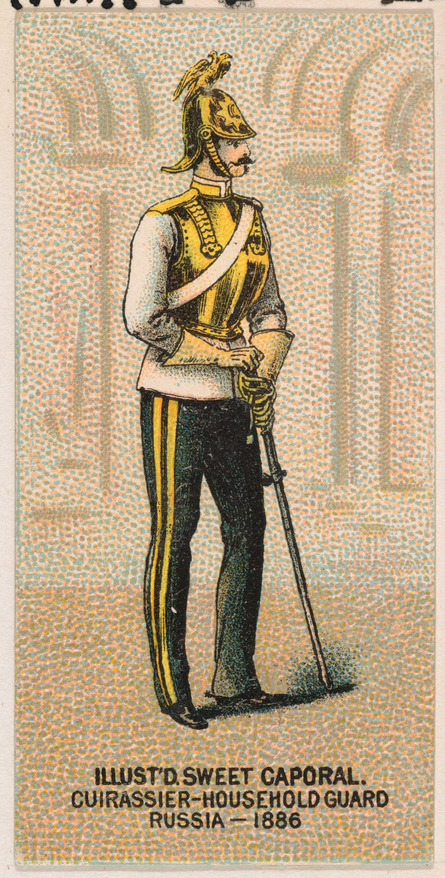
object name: print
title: Cuirassier Household Guard, Russia, 1886, from the Military Series (N224) issued by Kinney Tobacco Company to promote Sweet Caporal Cigarettes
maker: kinney brothers tobacco company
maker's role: publisher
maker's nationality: american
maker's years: 1869-2011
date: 1888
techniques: color lithograph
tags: military,men,profiles